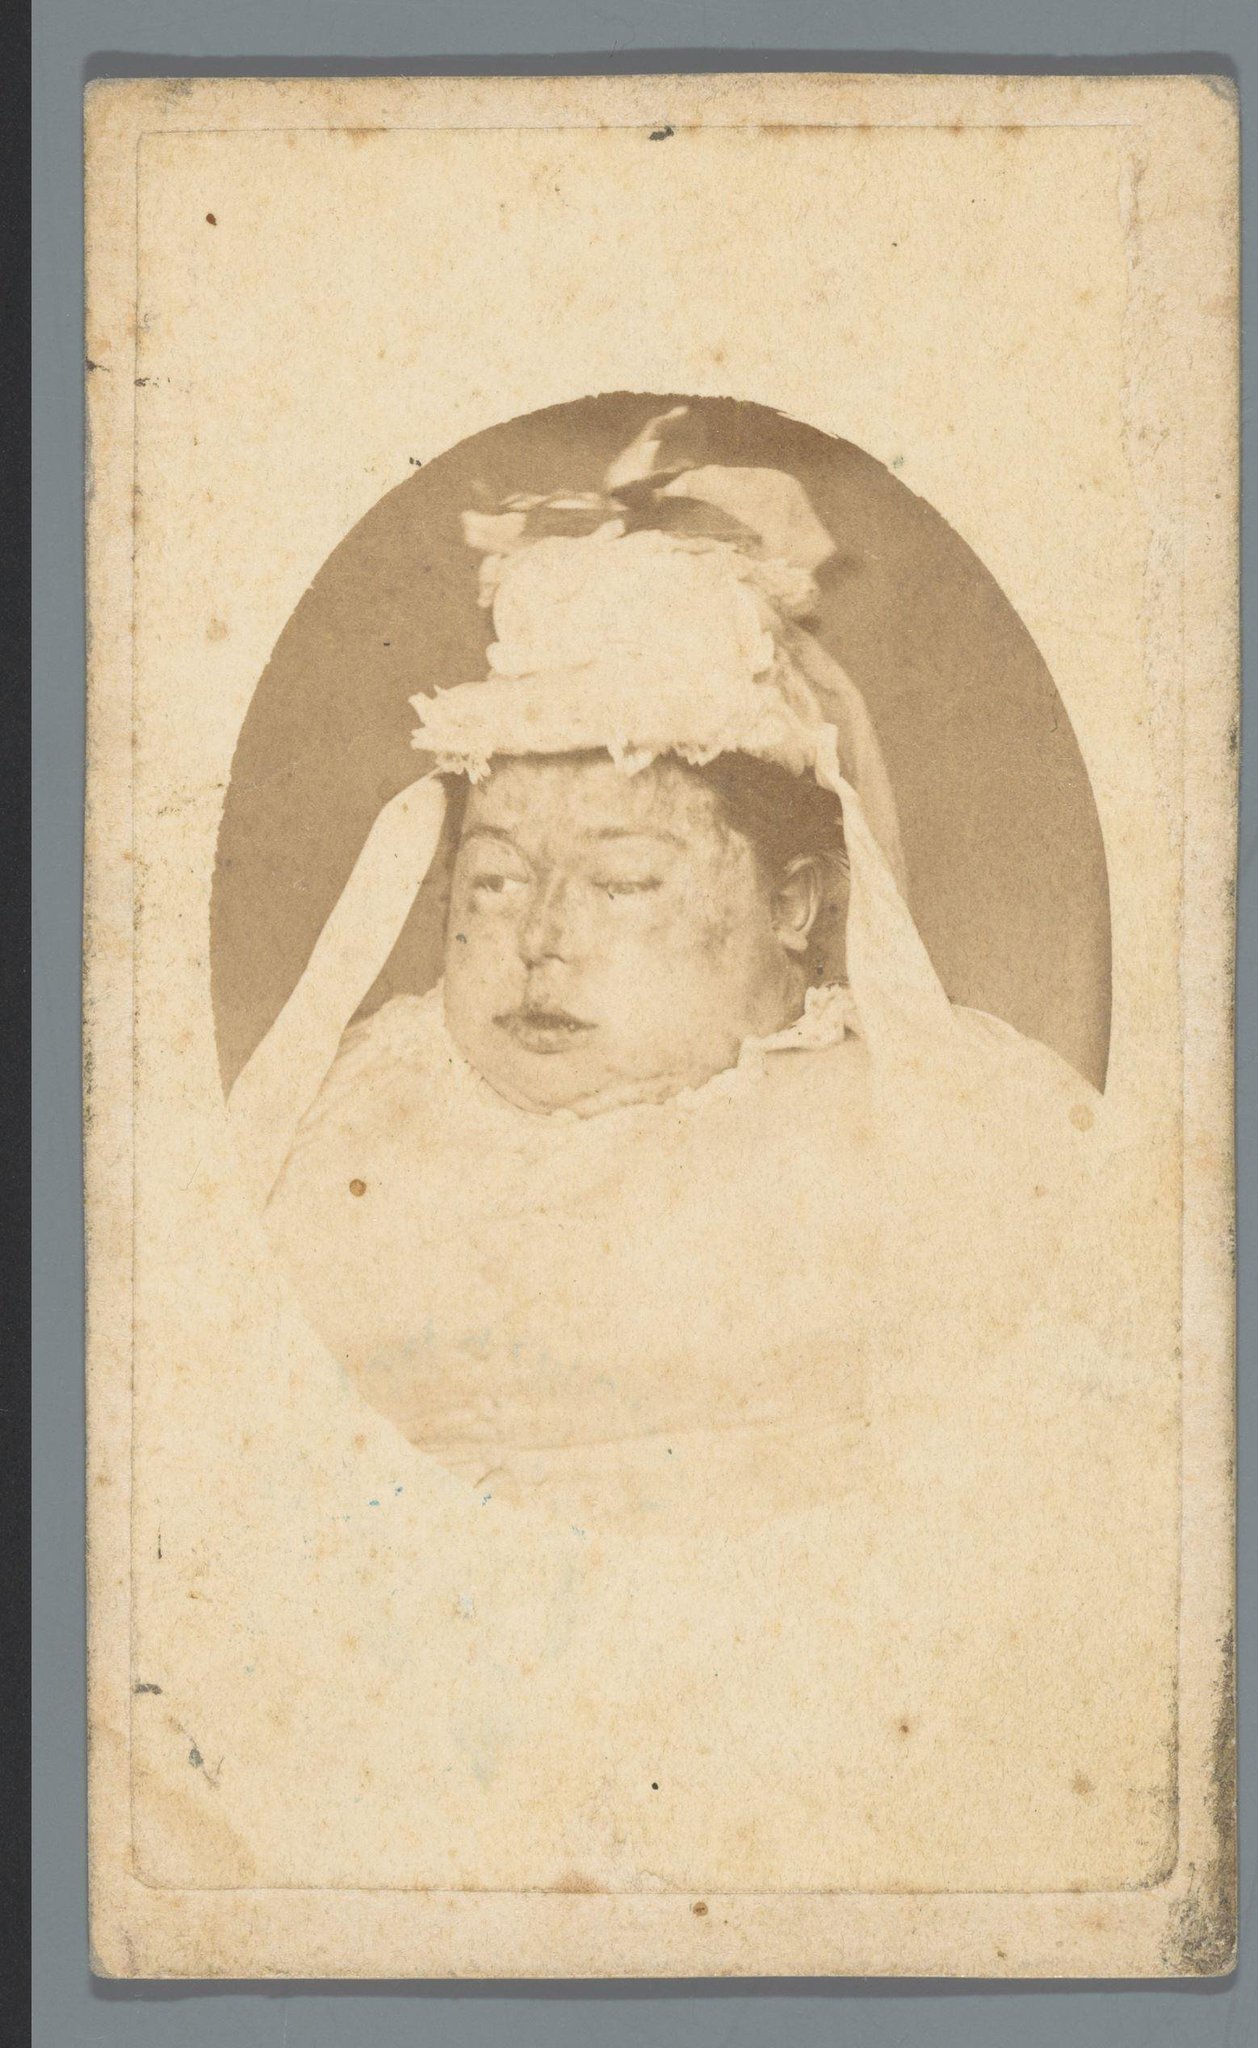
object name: carte de visite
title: Post-mortemportret van een onbekende vrouw in kleding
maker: Anonymous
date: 1855-1885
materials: cardboard, paper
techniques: albumen print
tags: adult woman, historical persons not known by name - bb - woman